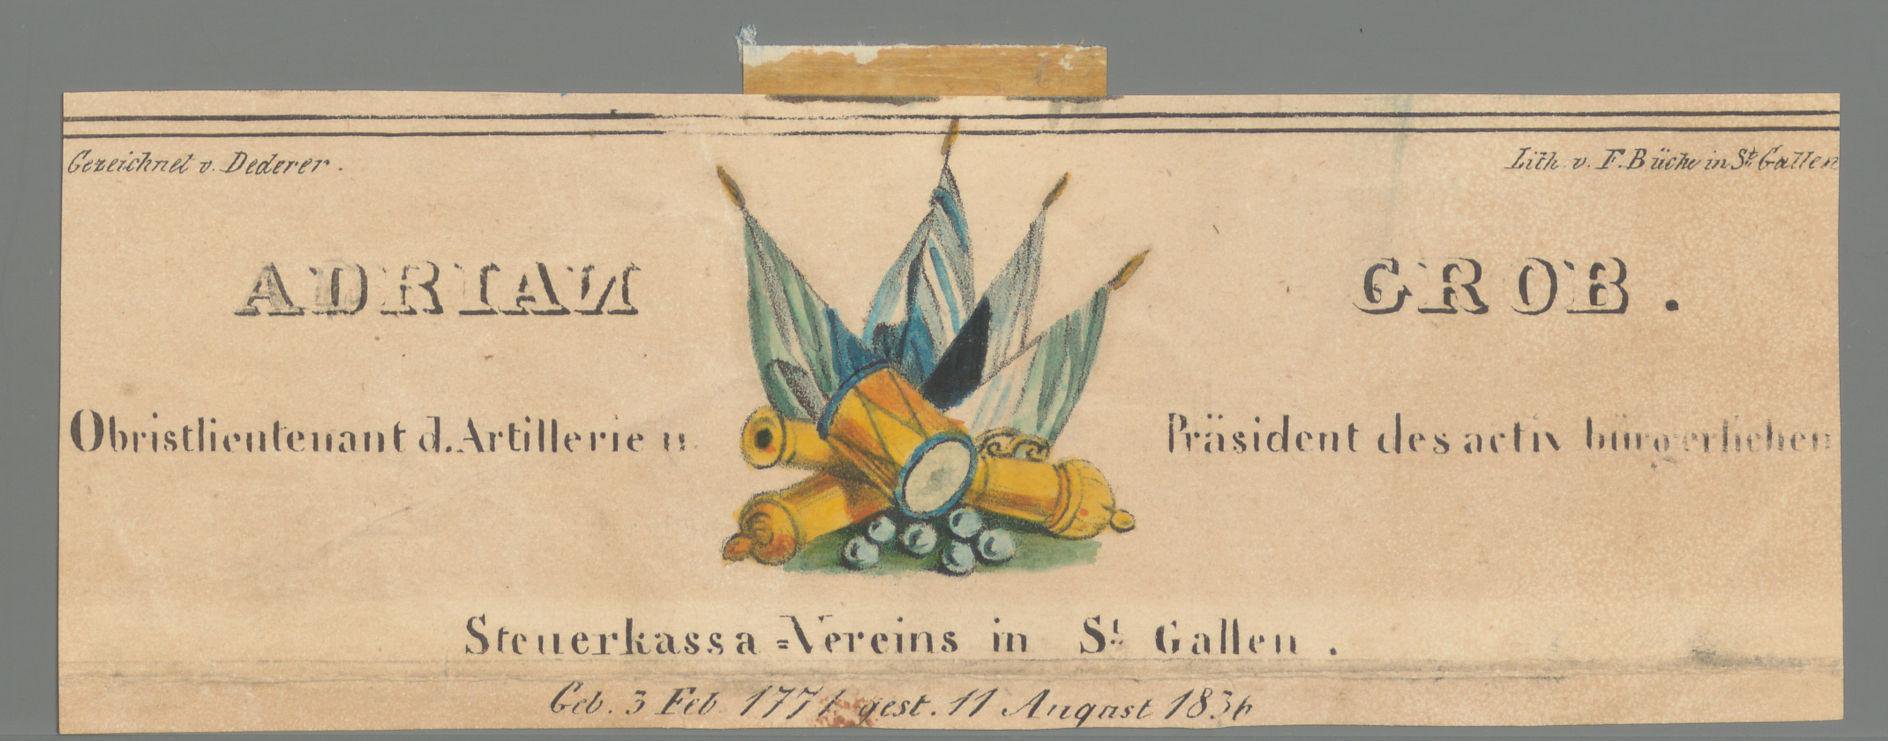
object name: print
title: Adrian Grob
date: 1836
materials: paper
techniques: hand coloring, lithograph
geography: sankt gallen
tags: adult man, historical persons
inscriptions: date